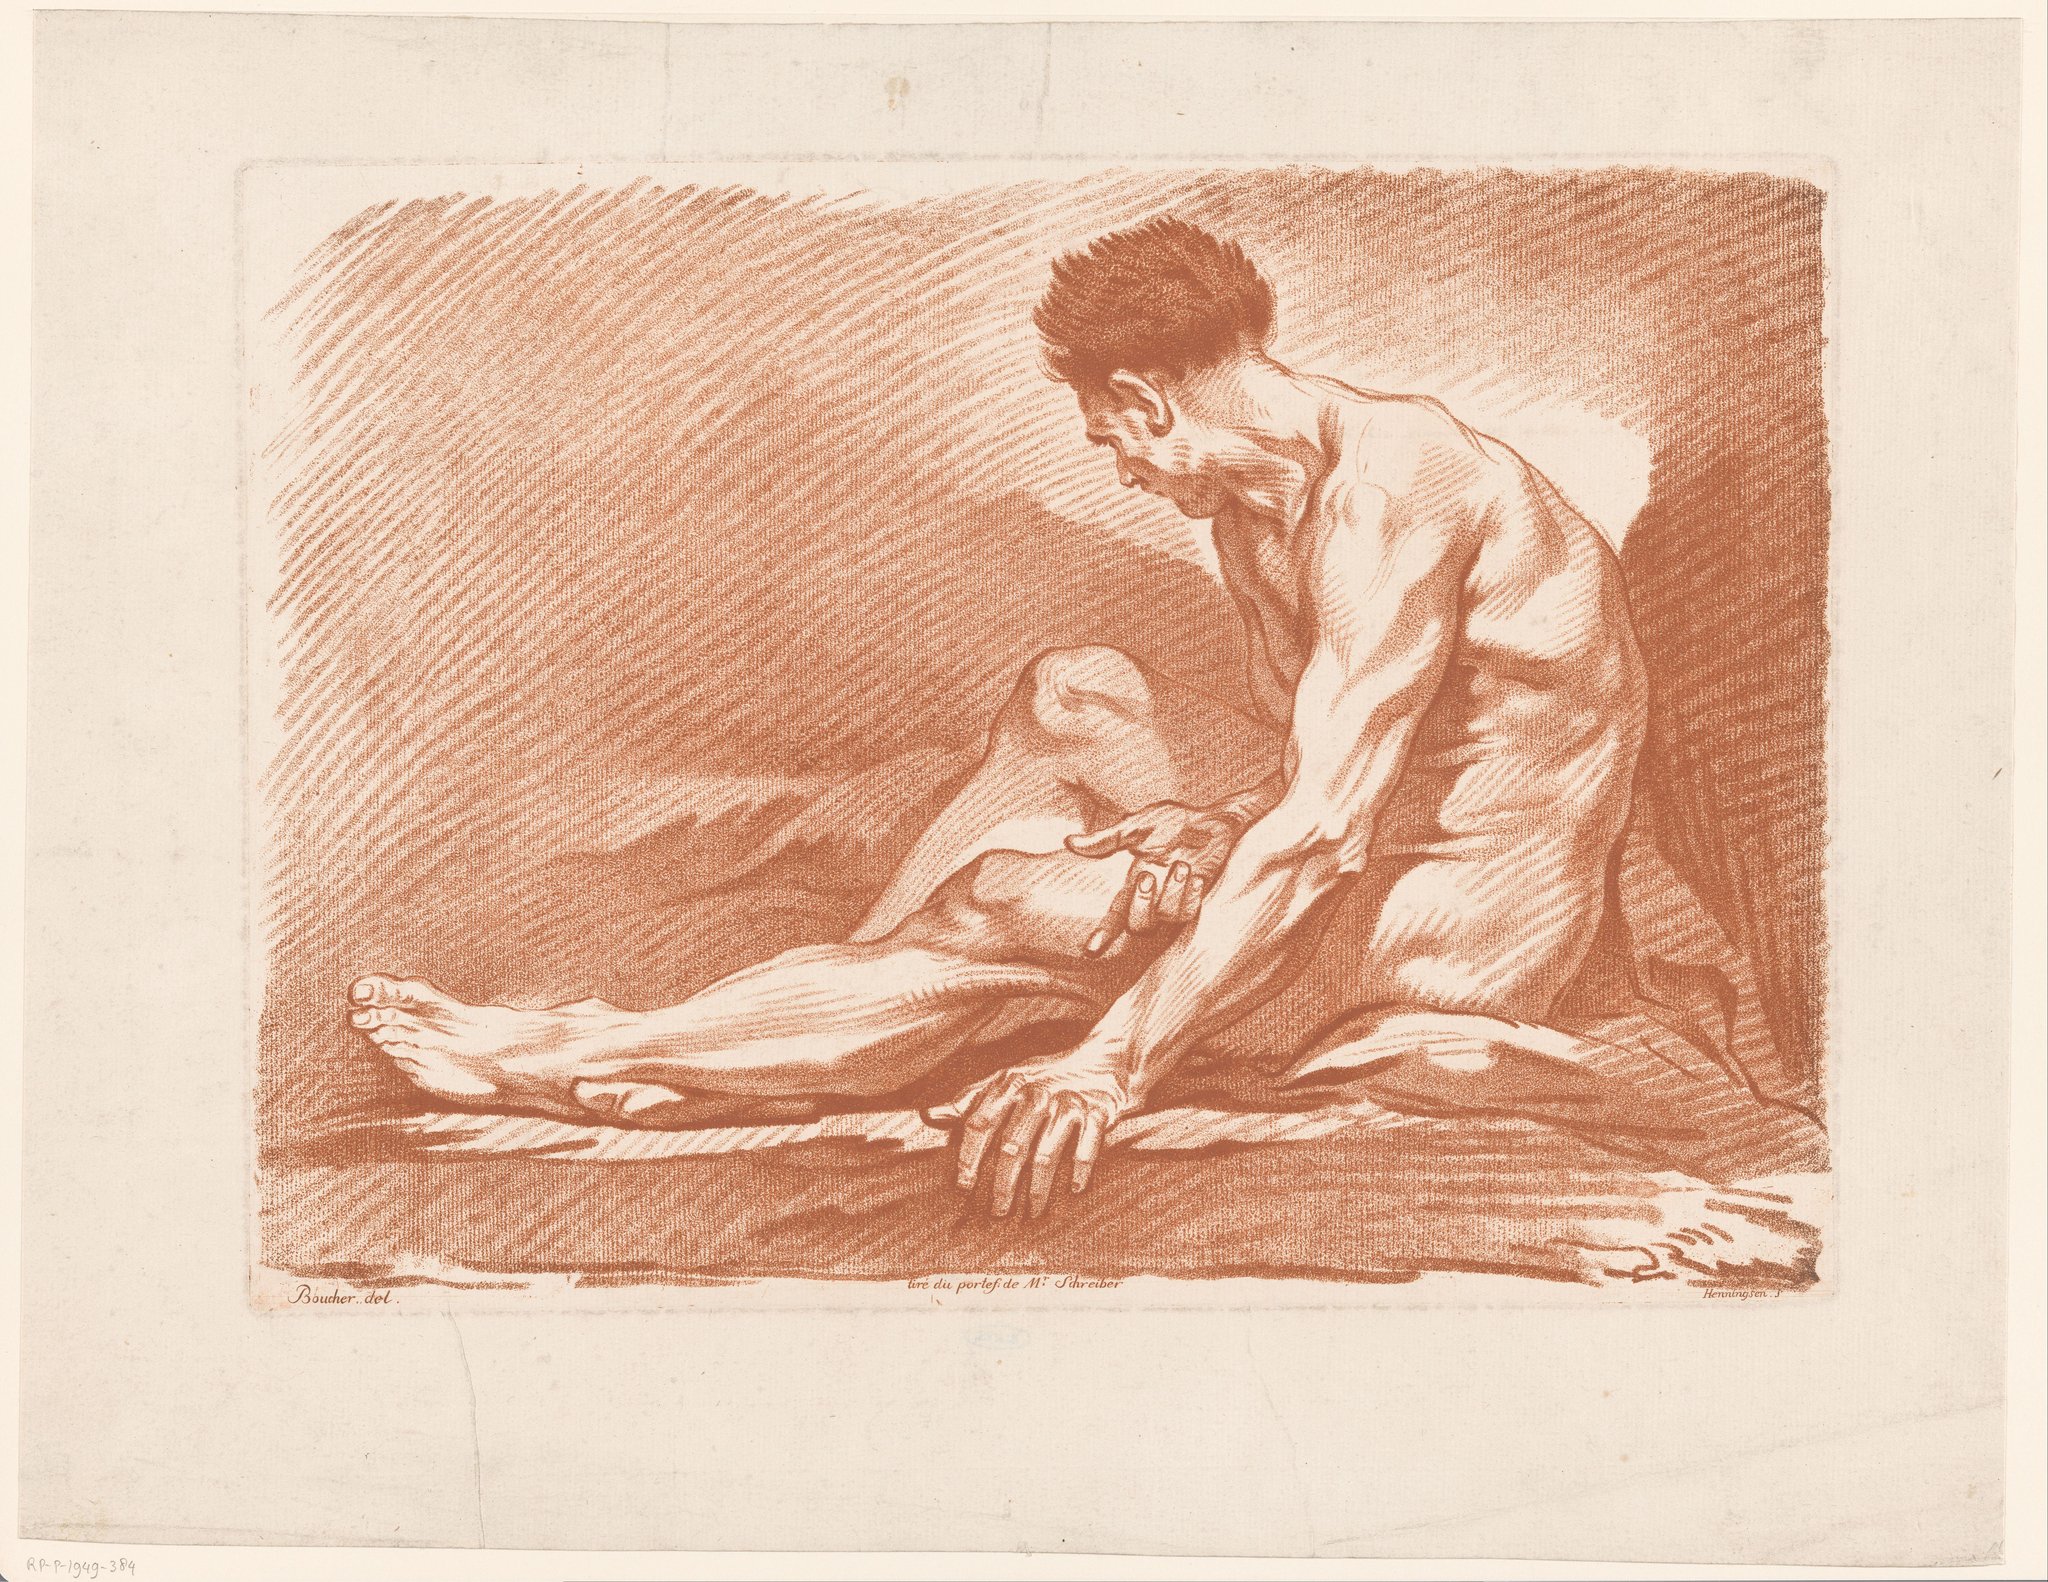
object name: print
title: Studie zittende man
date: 1700-1759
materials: paper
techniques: printing, printmaking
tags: sitting on the ground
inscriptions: collector's mark: Lugt 2228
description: Academische studie van een zittende naakte man.